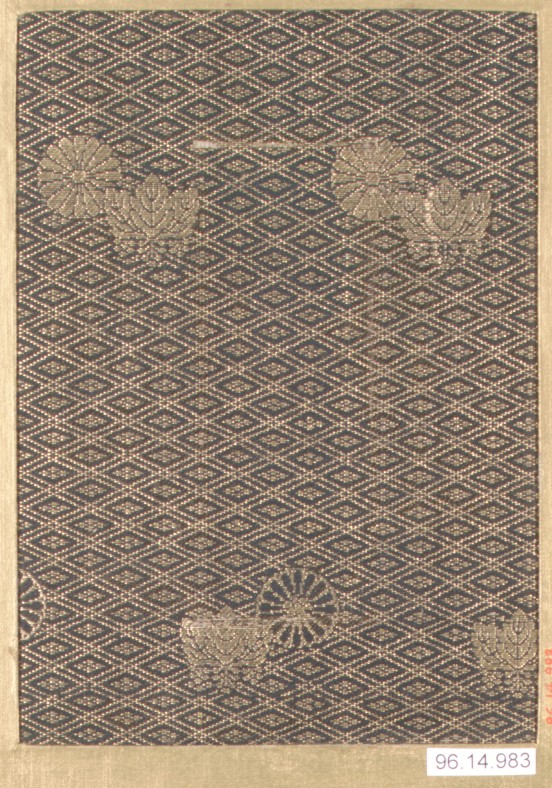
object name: piece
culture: japanese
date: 1701-1900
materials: silk